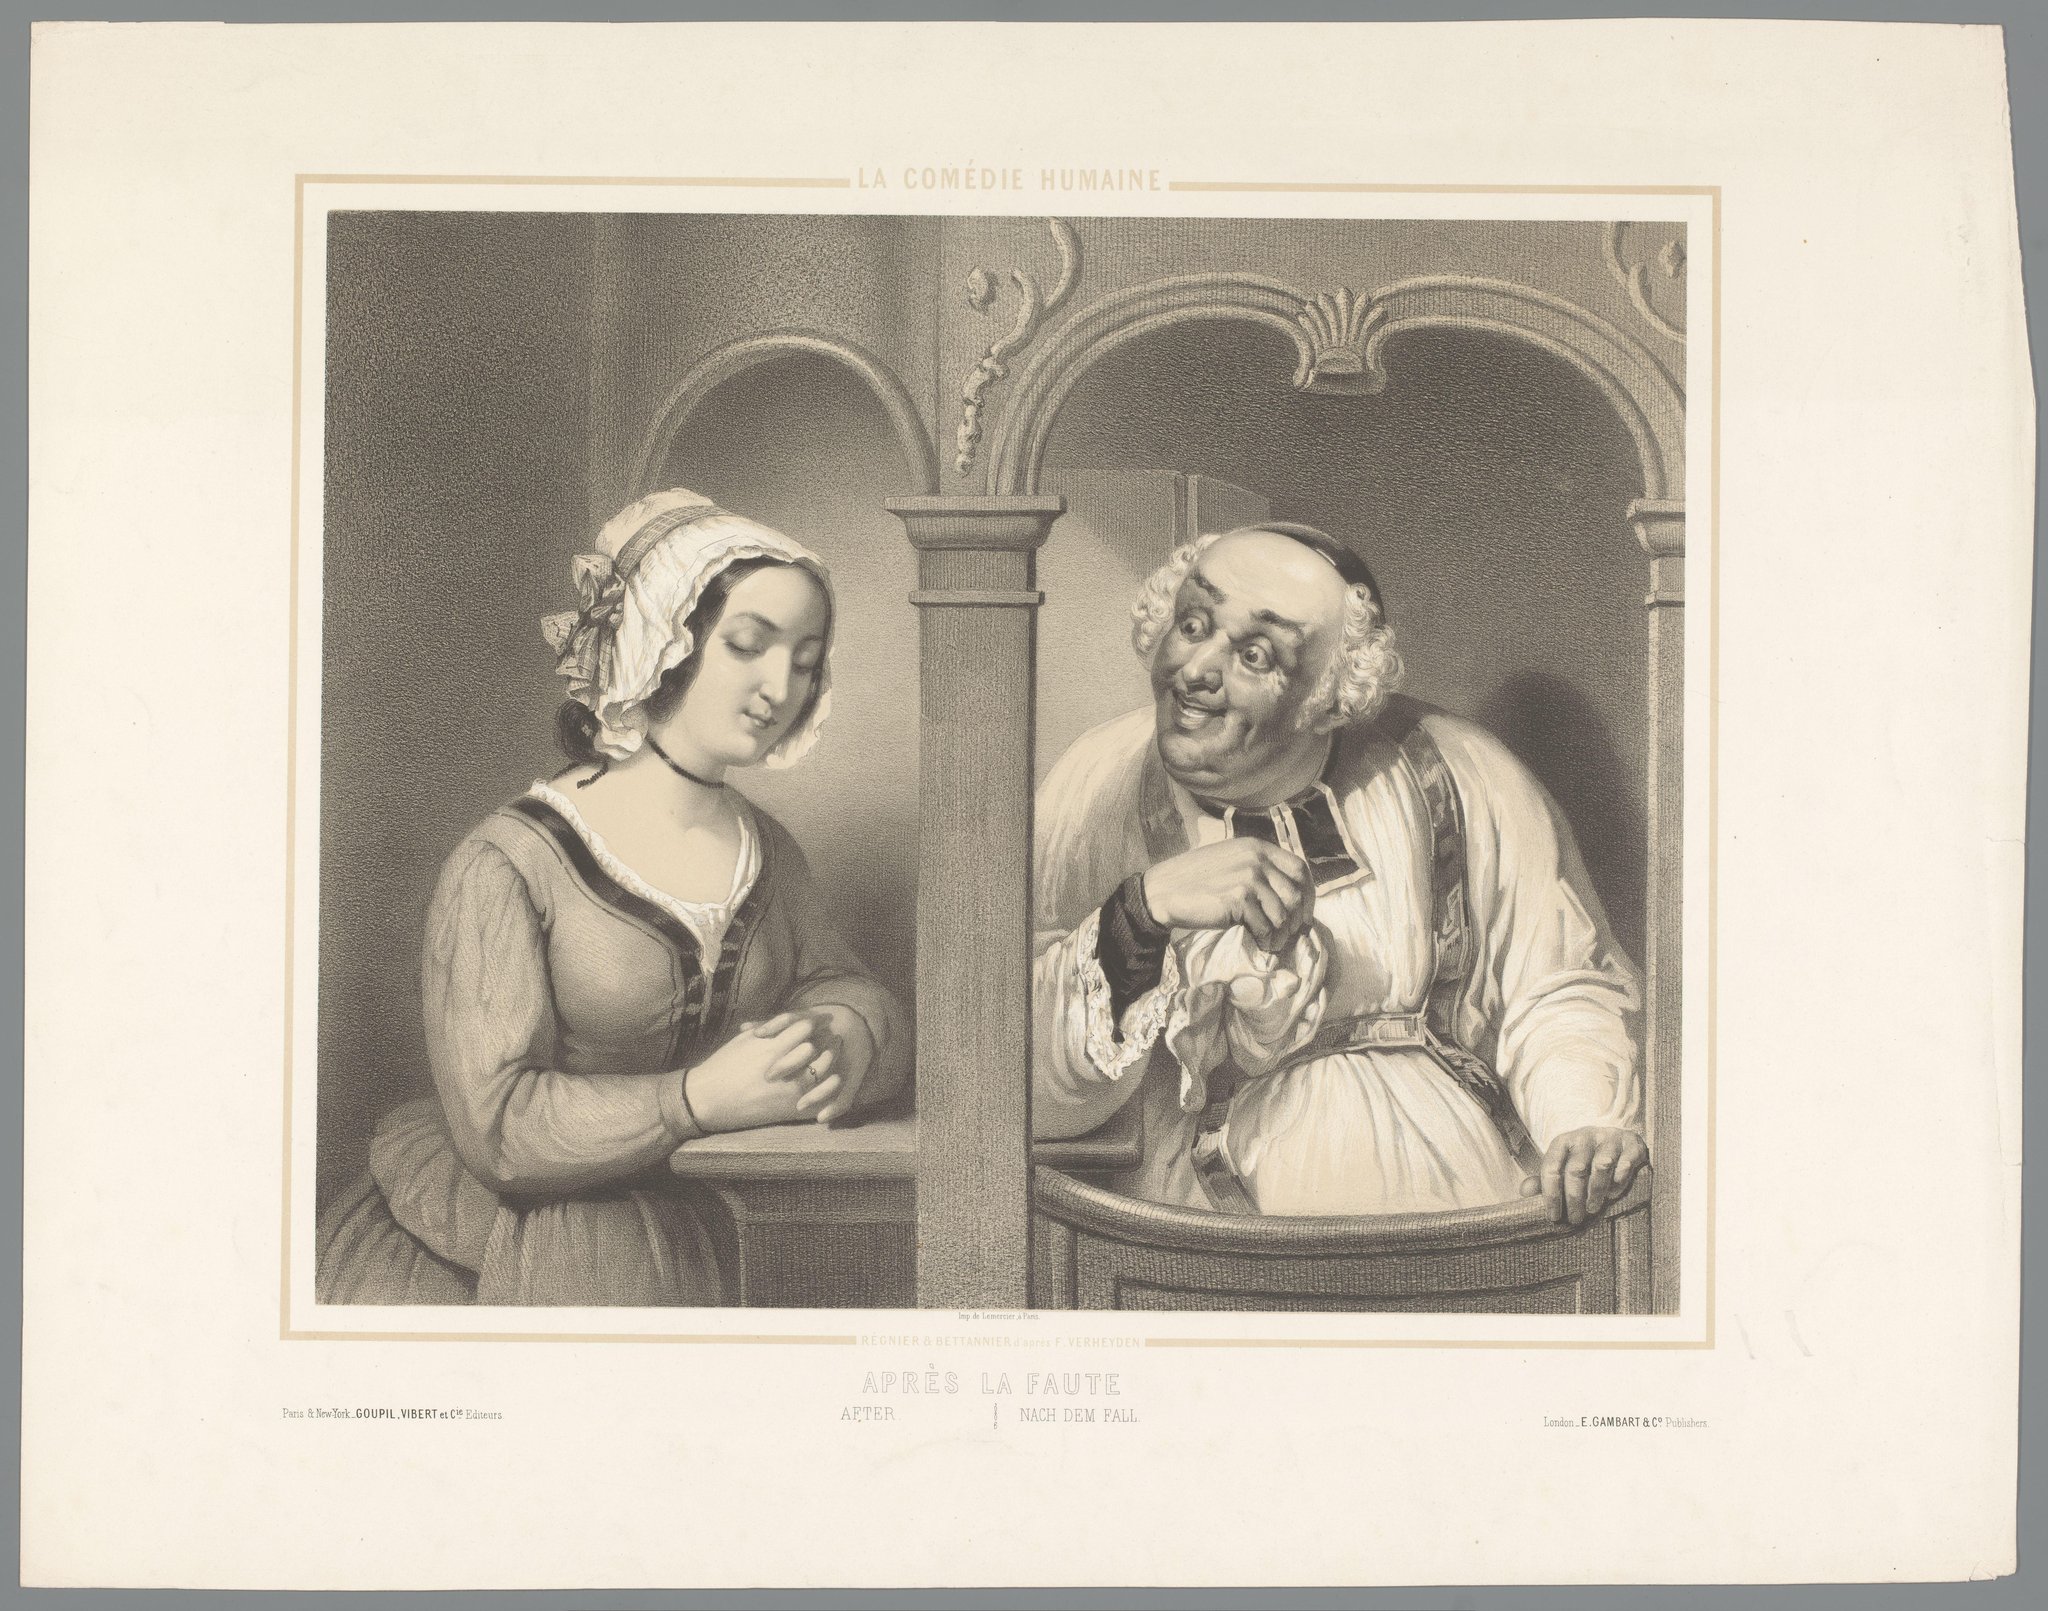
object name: cartoon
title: Après la faute / after / nach dem Fall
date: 1848-1850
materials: paper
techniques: tone lithography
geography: new york city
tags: adult woman, priest (roman catholic)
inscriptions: collector's mark: Lugt 2228